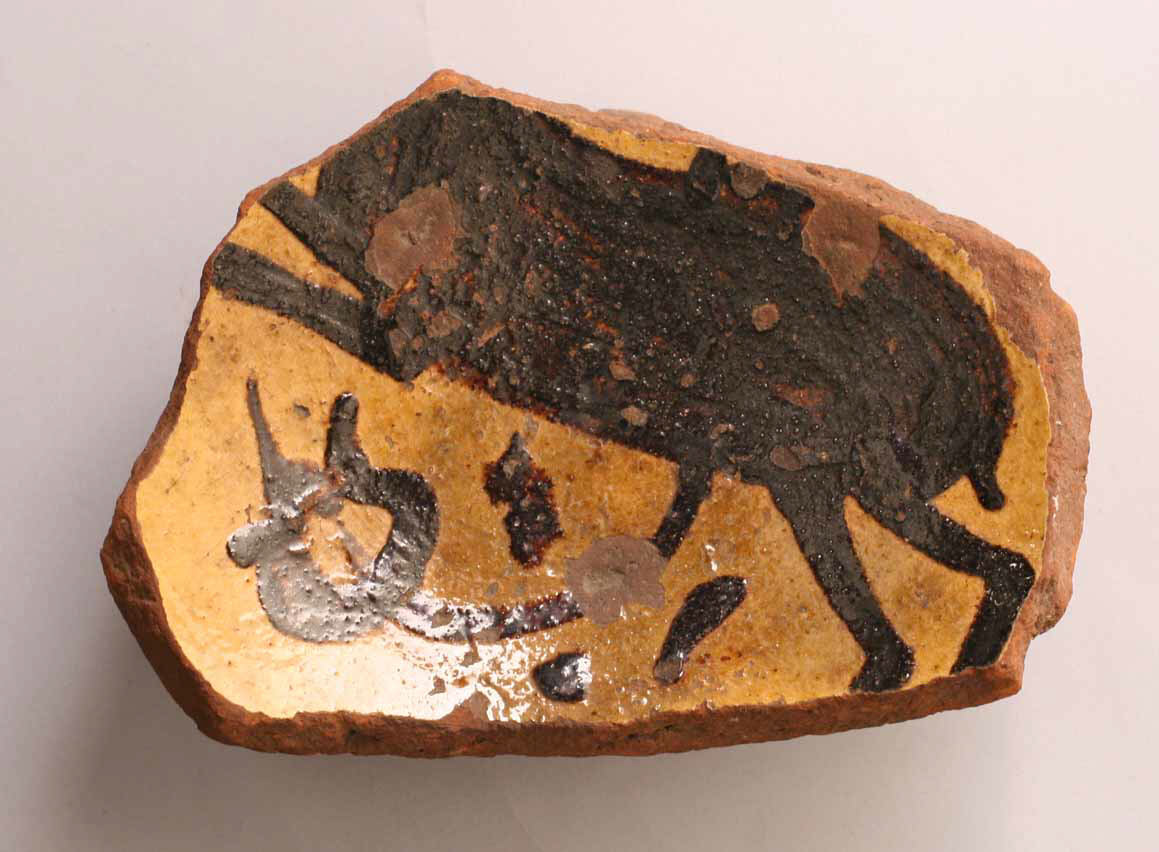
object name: fragment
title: Ceramic Fragment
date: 1301-1500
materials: earthenware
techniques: painting